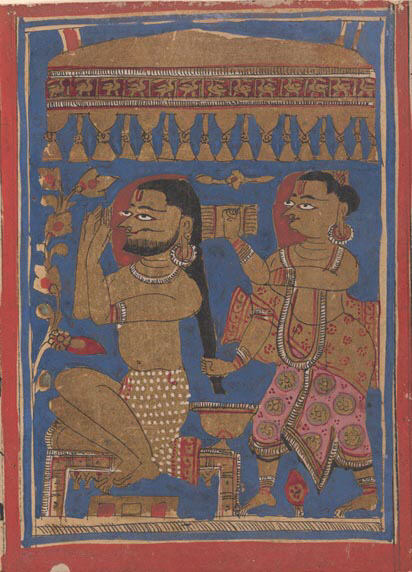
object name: folio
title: King Siddharta Bathing: Folio from a Kalpasutra Manuscript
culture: indian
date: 1401-1500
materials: gold, ink, paper, watercolor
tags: kings,bathing